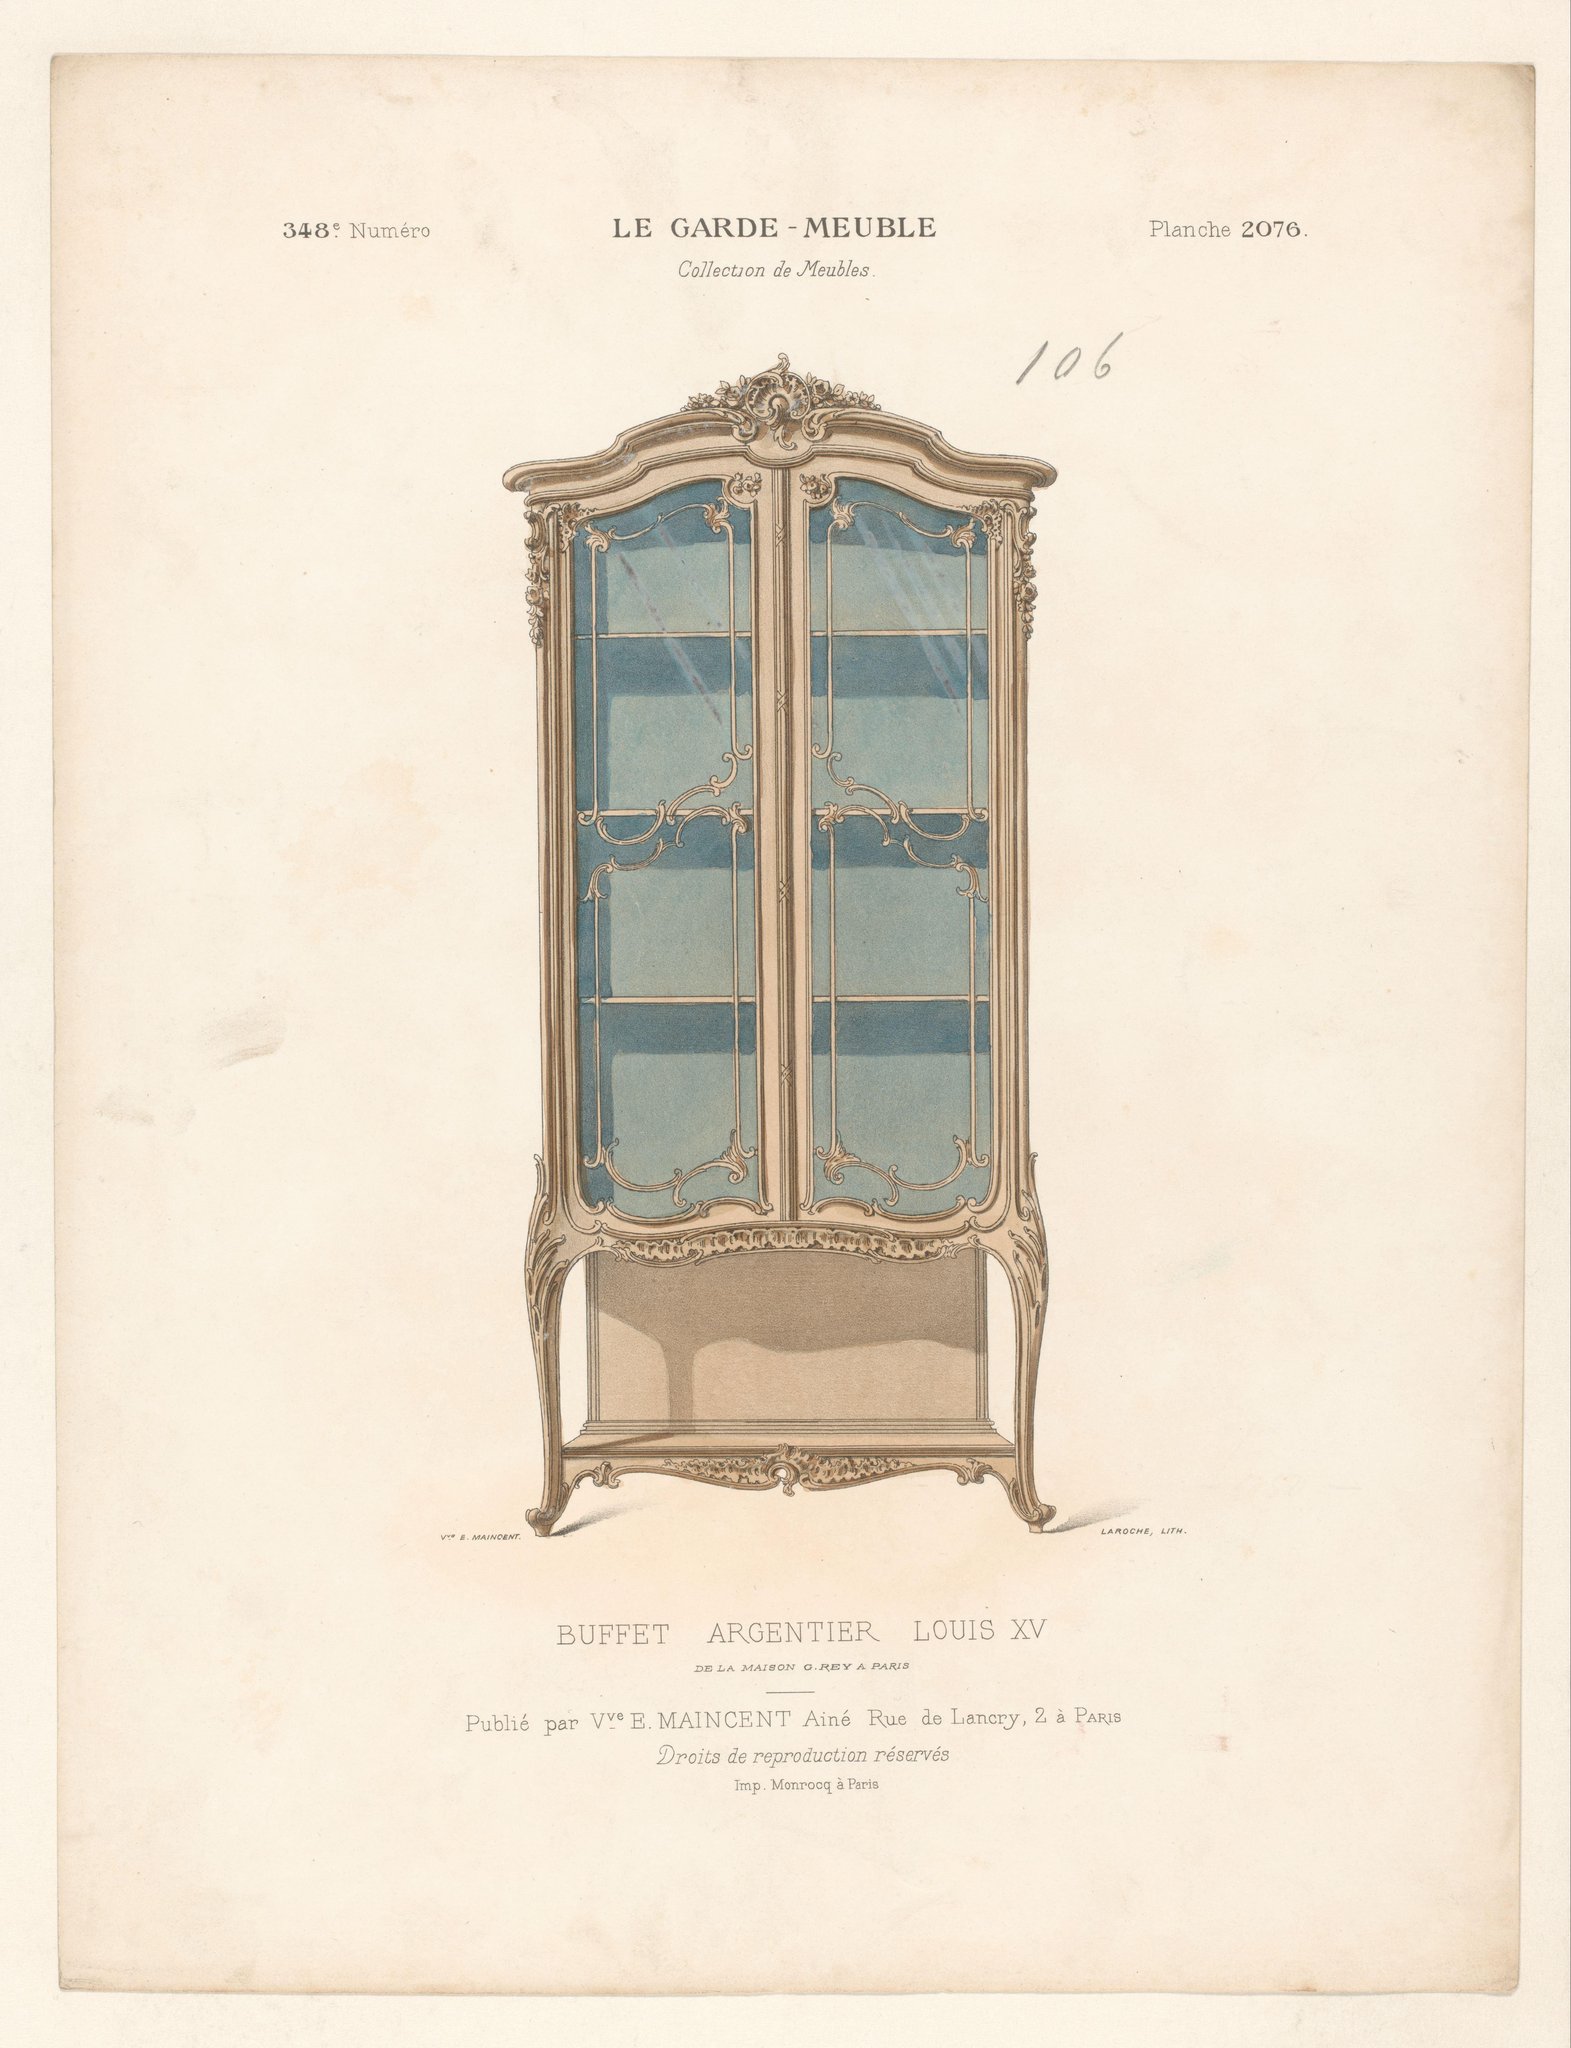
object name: print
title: Le garde-meuble / Collection de Meubles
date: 1895-1935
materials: paper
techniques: hand coloring, lithograph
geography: paris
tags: furniture for storage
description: Ieder Livraison in de serie Le Garde-Meuble bevat negen platen: drie 'sièges' (zitmeubels), drie 'meubles' (diverse meubels zoals tafels en kasten) en drie 'tentures' (gordijnen en draperieën).